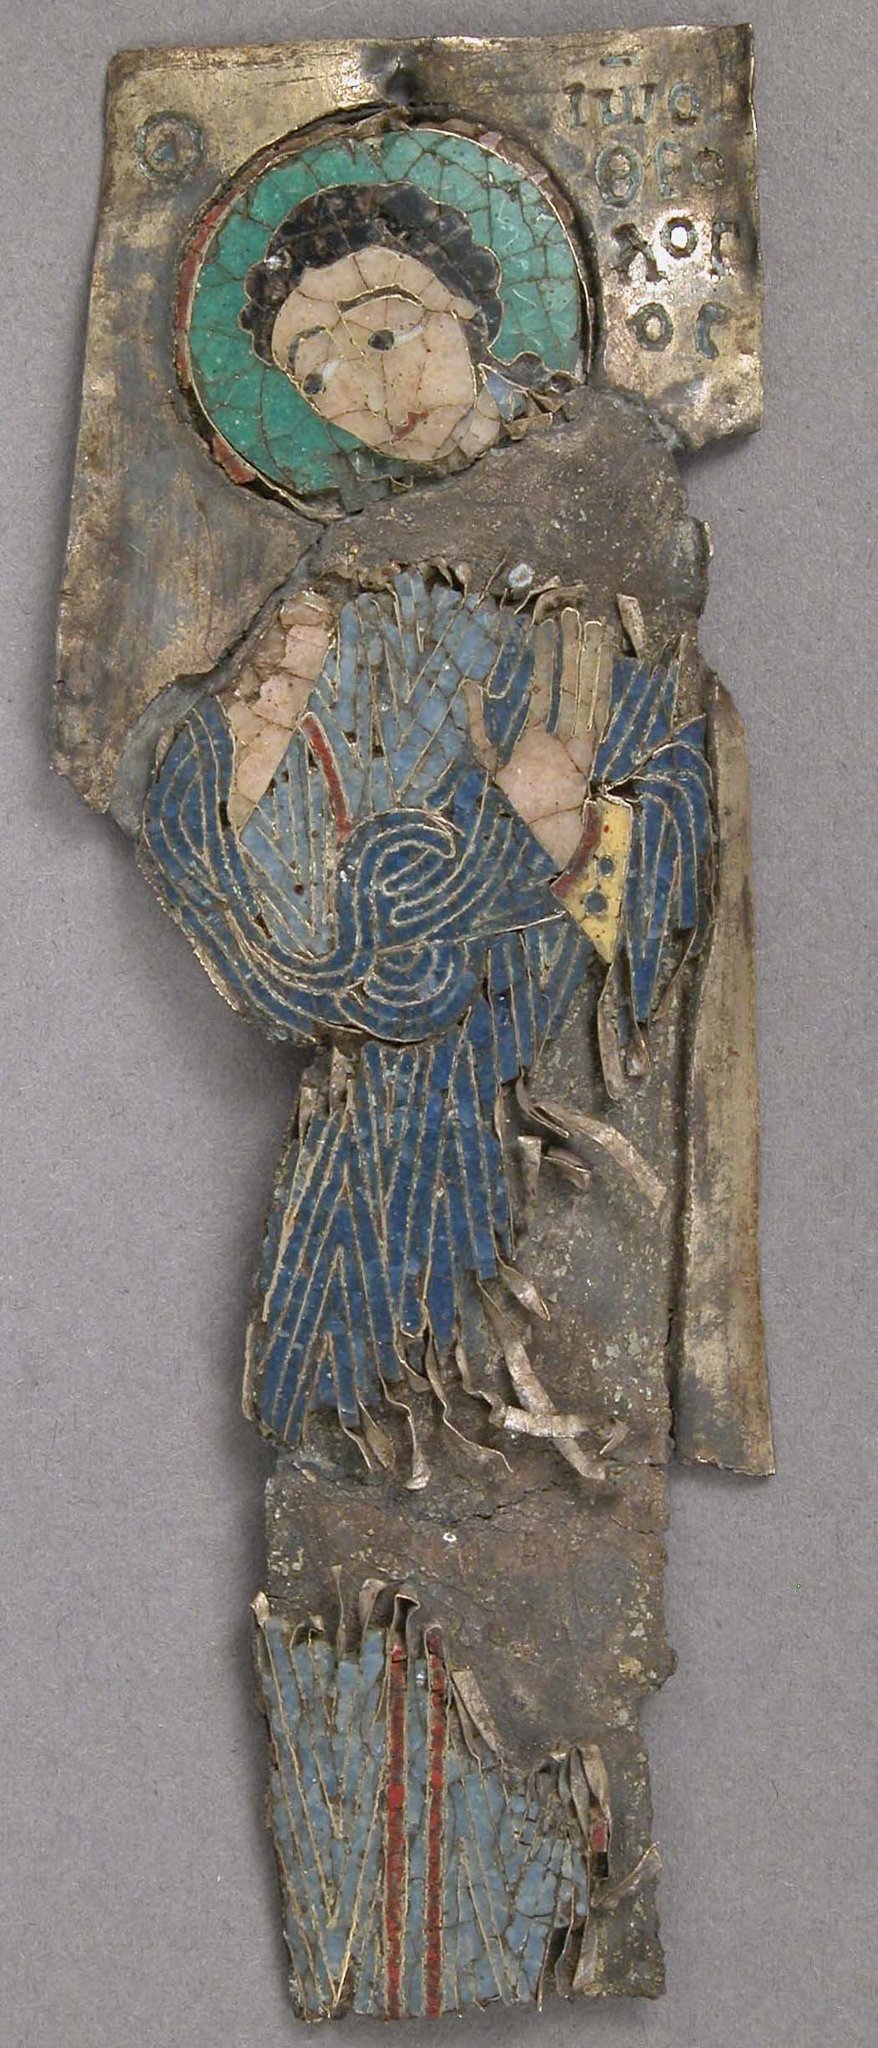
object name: plaque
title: Plaque of St. John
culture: byzantine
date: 1101-1200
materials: enamel, silver gilt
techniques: enamel